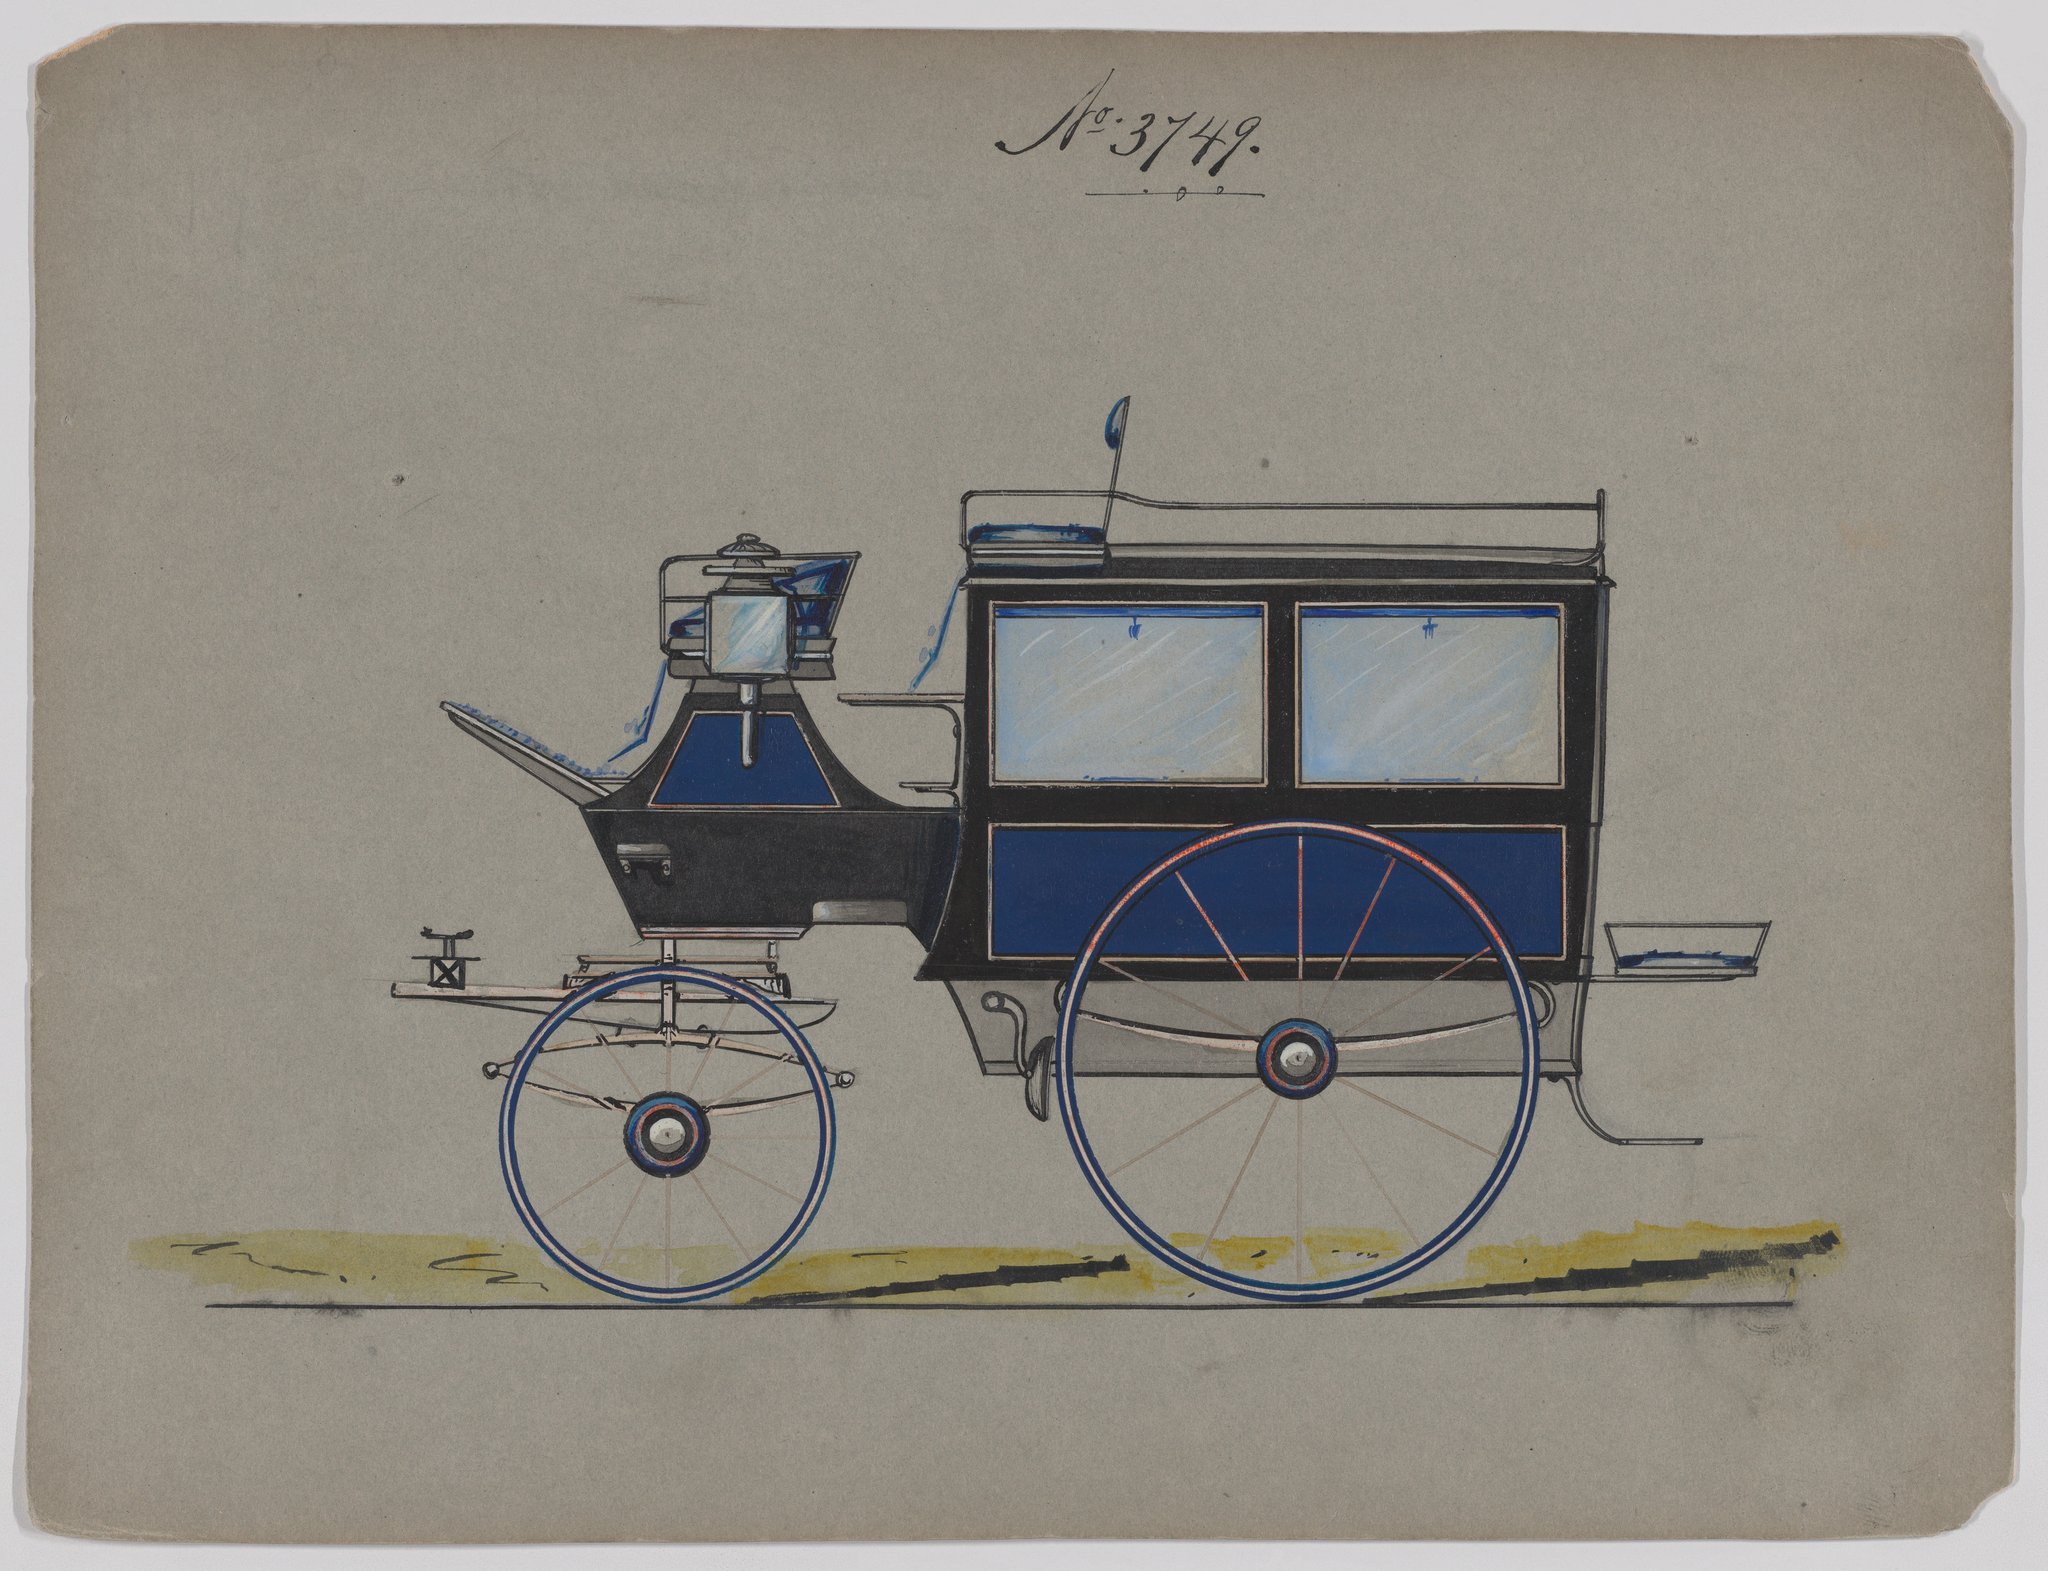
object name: drawing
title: Design for Omnibus or Wagonette, no. 3749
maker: brewster & co.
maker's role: manufacturer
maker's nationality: american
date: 1882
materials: gouache, gum arabic, ink, watercolor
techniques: pen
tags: carriages